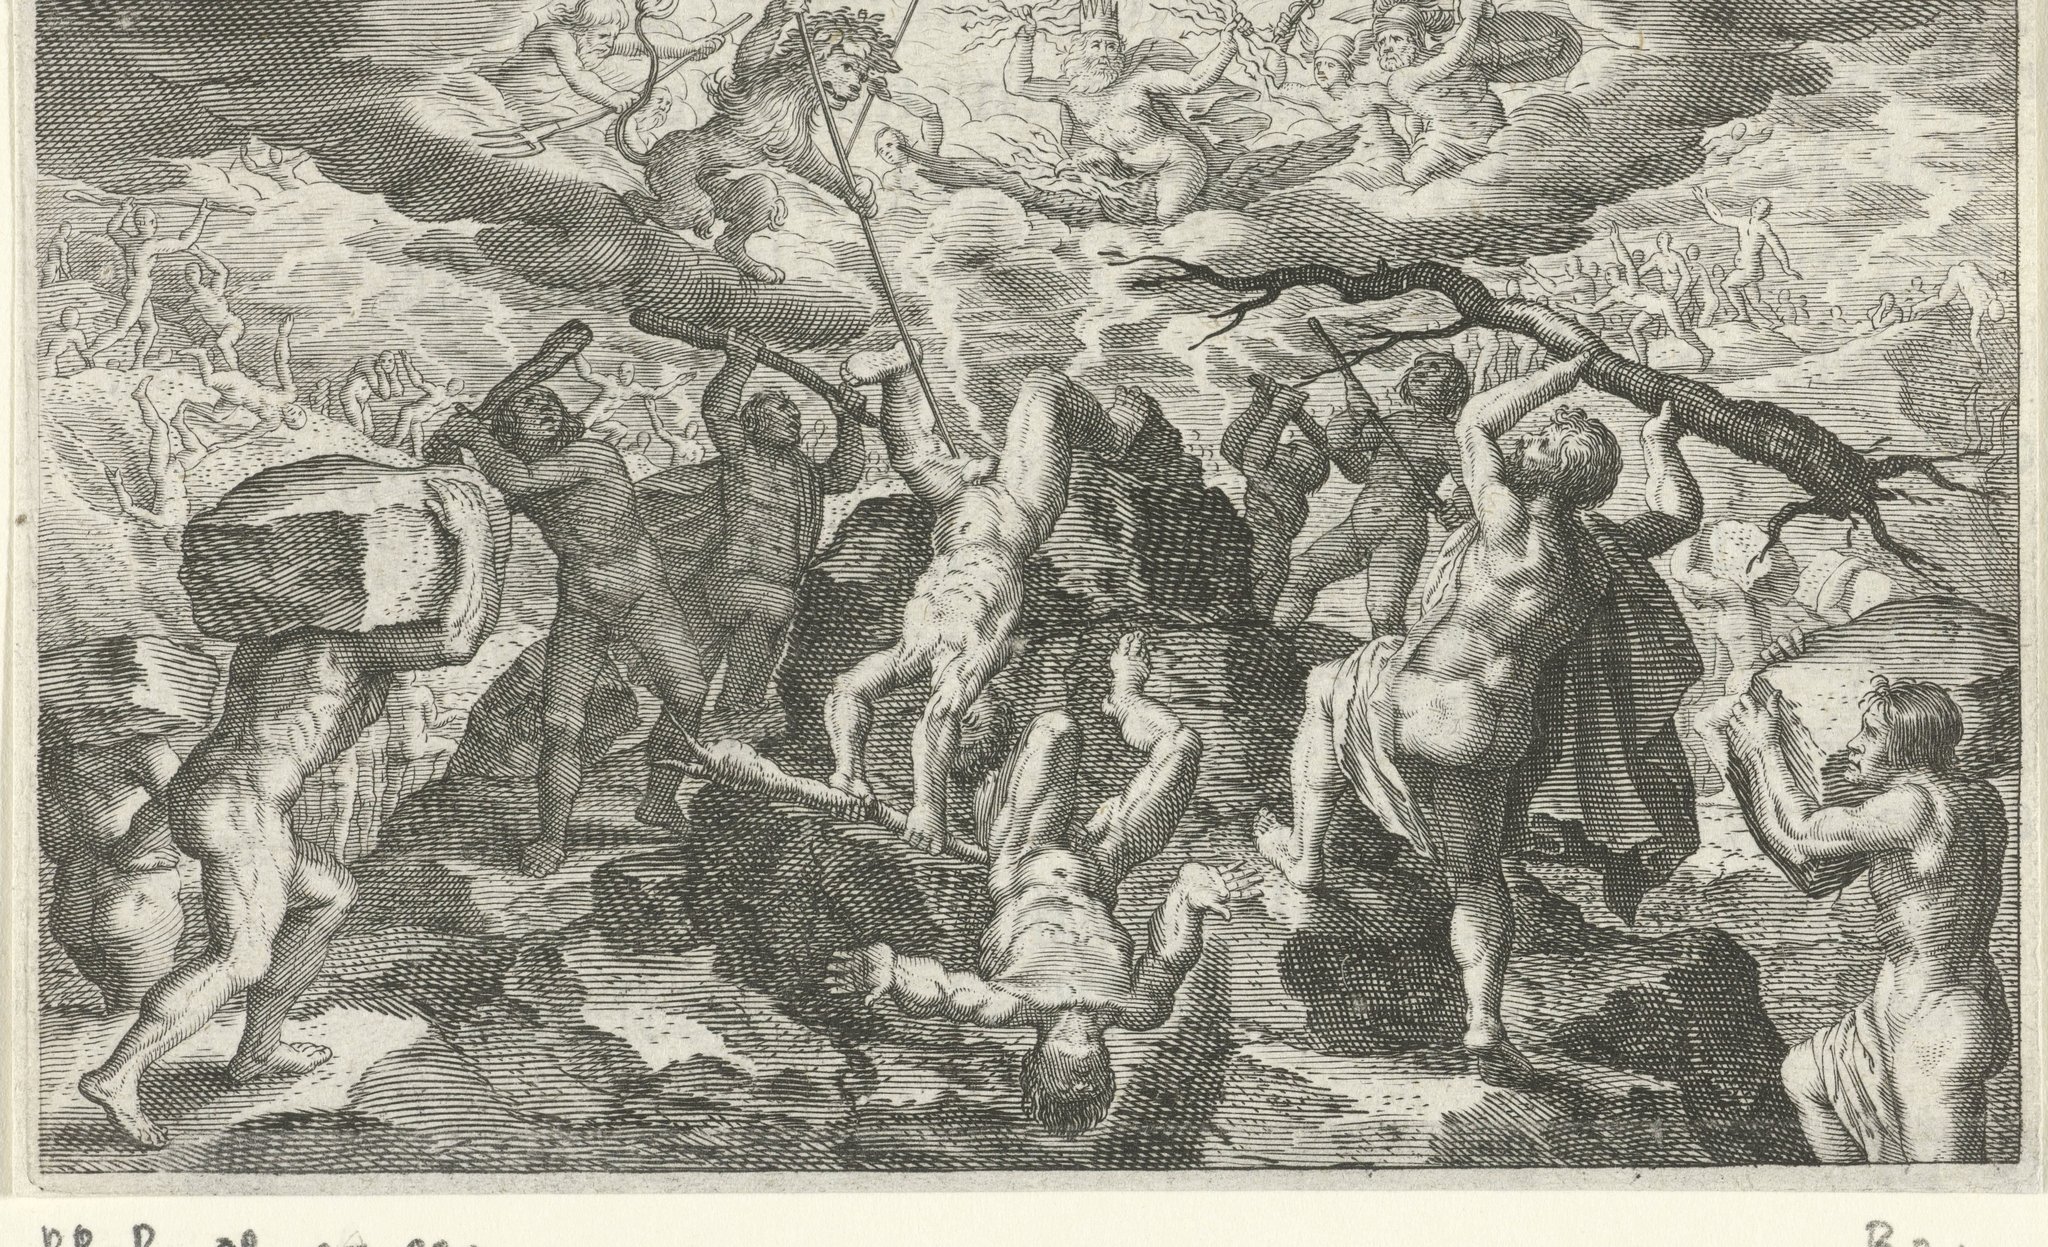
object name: book illustration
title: Bacchus helpt de Titanen verslaan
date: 1616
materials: paper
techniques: engraving, letterpress printing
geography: amsterdam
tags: war of the titans against jupiter and allies: titanomachy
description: Boekillustratie voor: Heinsius, Daniel [bewerkt door Petrus Scriverius]. Nederduytsche poemata. dl. 3: Hymnus oft Lof-sanck van Bacchus, Waerin'tgebruyck ende misbruyck vande Wijn beschreven wort. Amsterdam: Willem Jansz Blaeu, 1616.